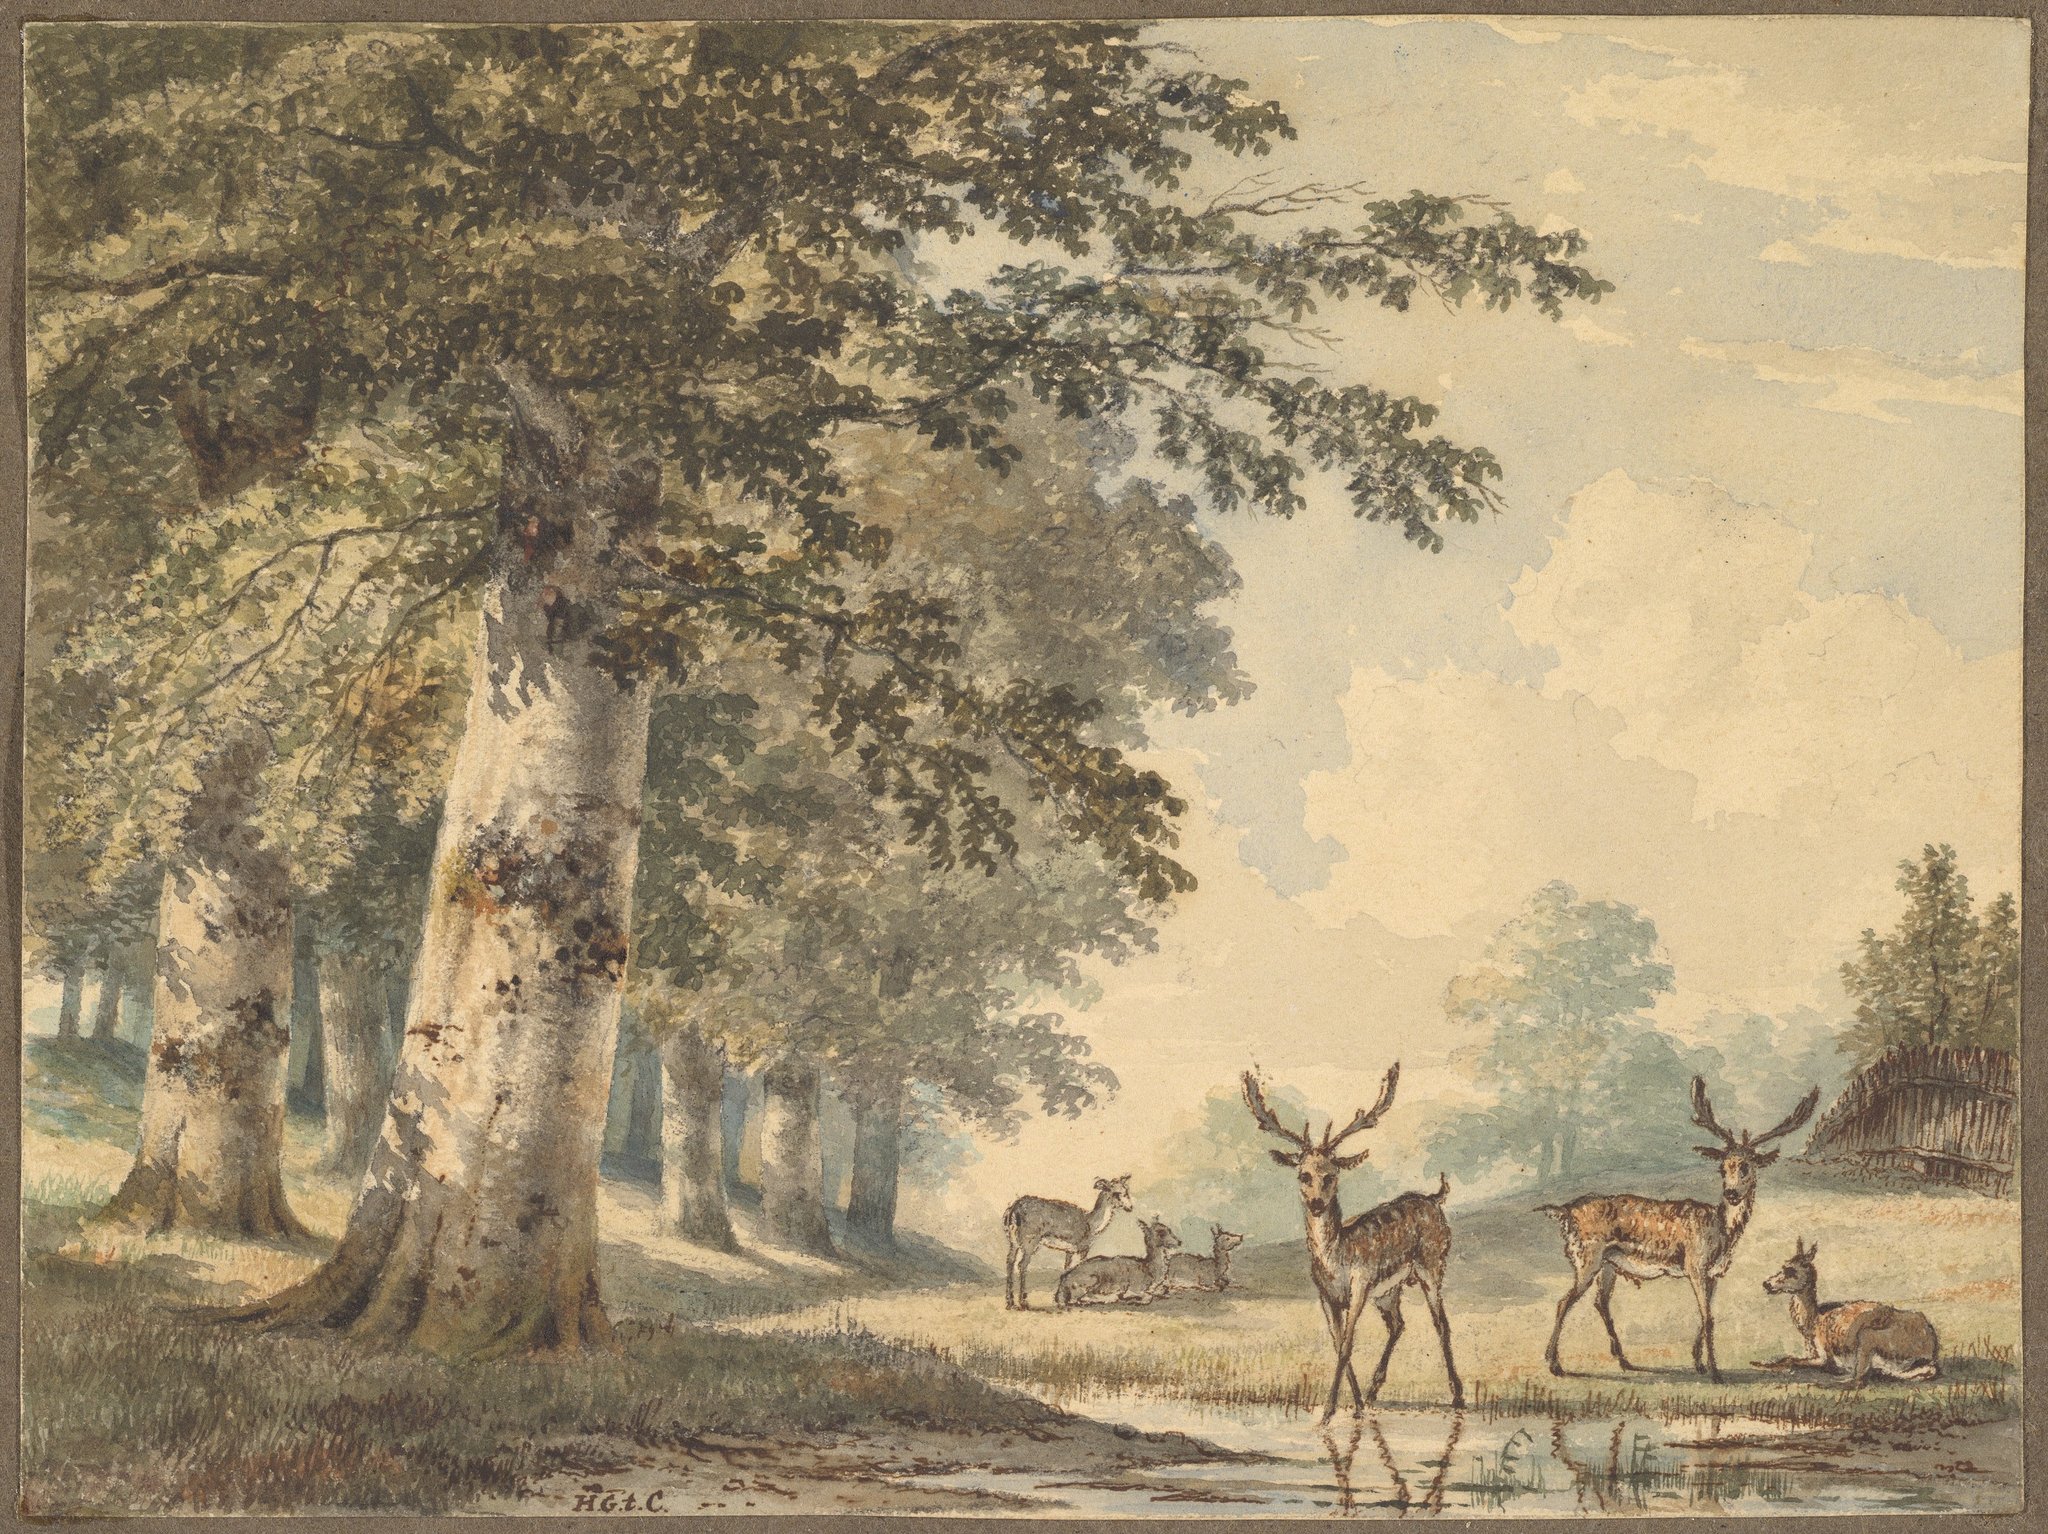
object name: drawing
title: Deer under Beech Trees in Winter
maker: hendrik gerrit ten cate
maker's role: artist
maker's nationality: dutch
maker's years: 1803-1856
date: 1853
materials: chalk, graphite, watercolor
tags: deer,landscapes,trees